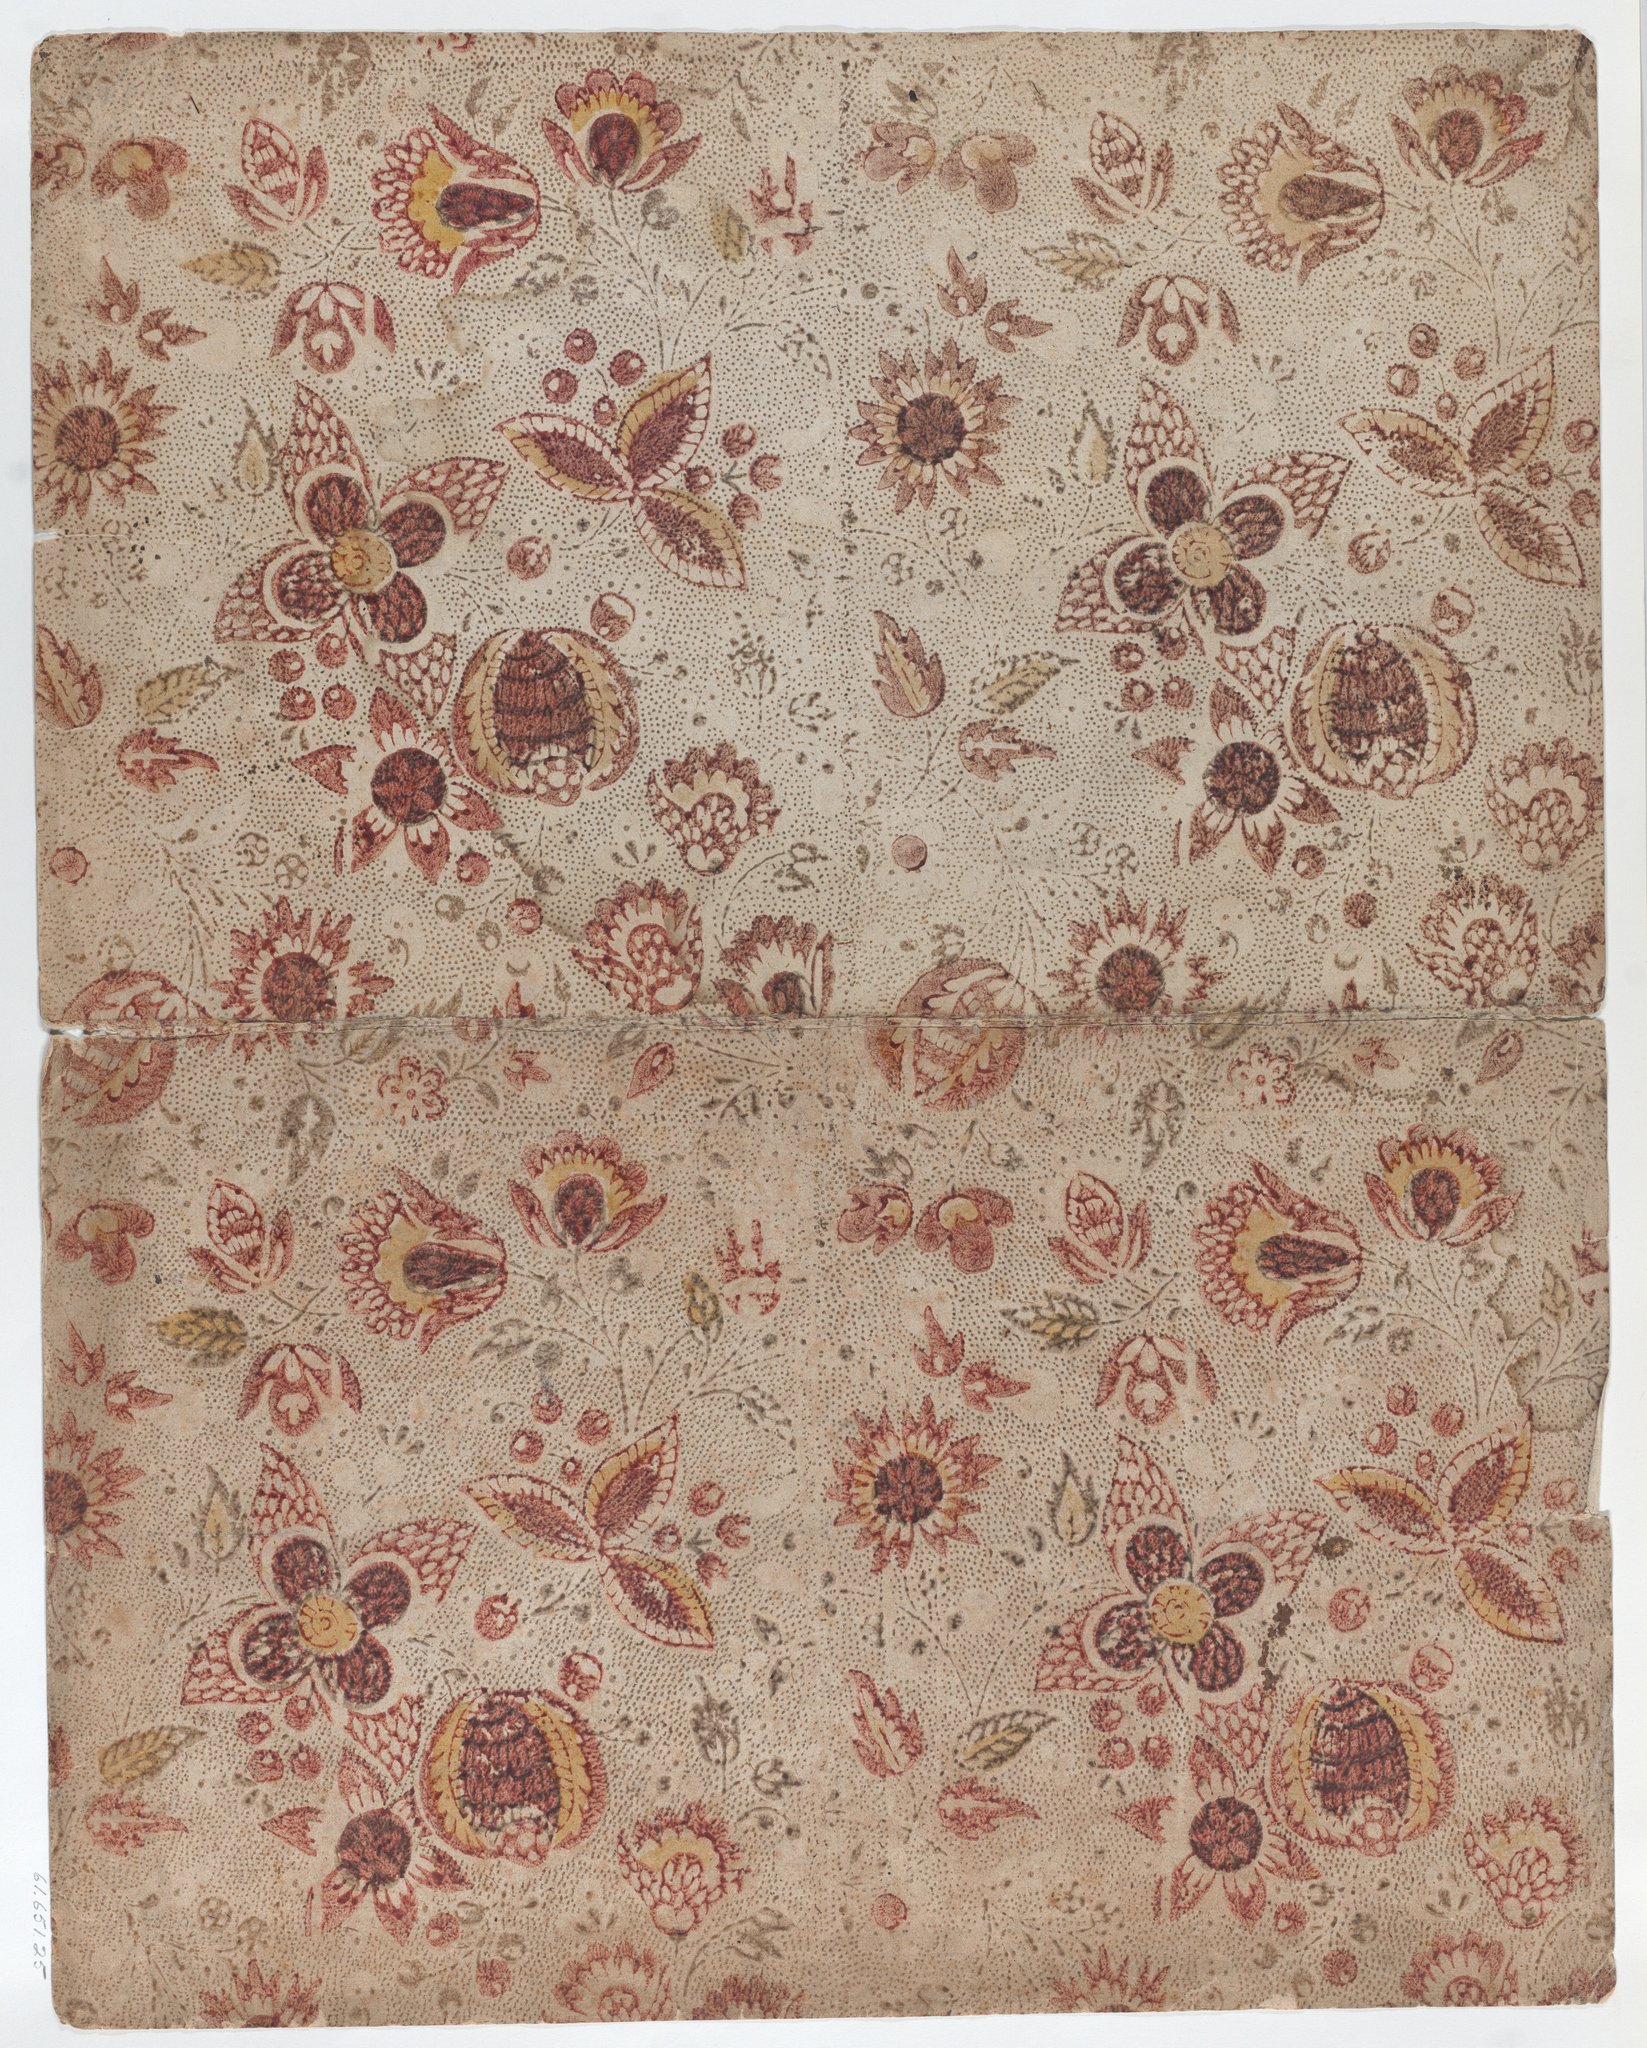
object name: print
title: Book cover with overall floral and dot pattern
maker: Anonymous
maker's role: artist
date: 1701-1800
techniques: relief print